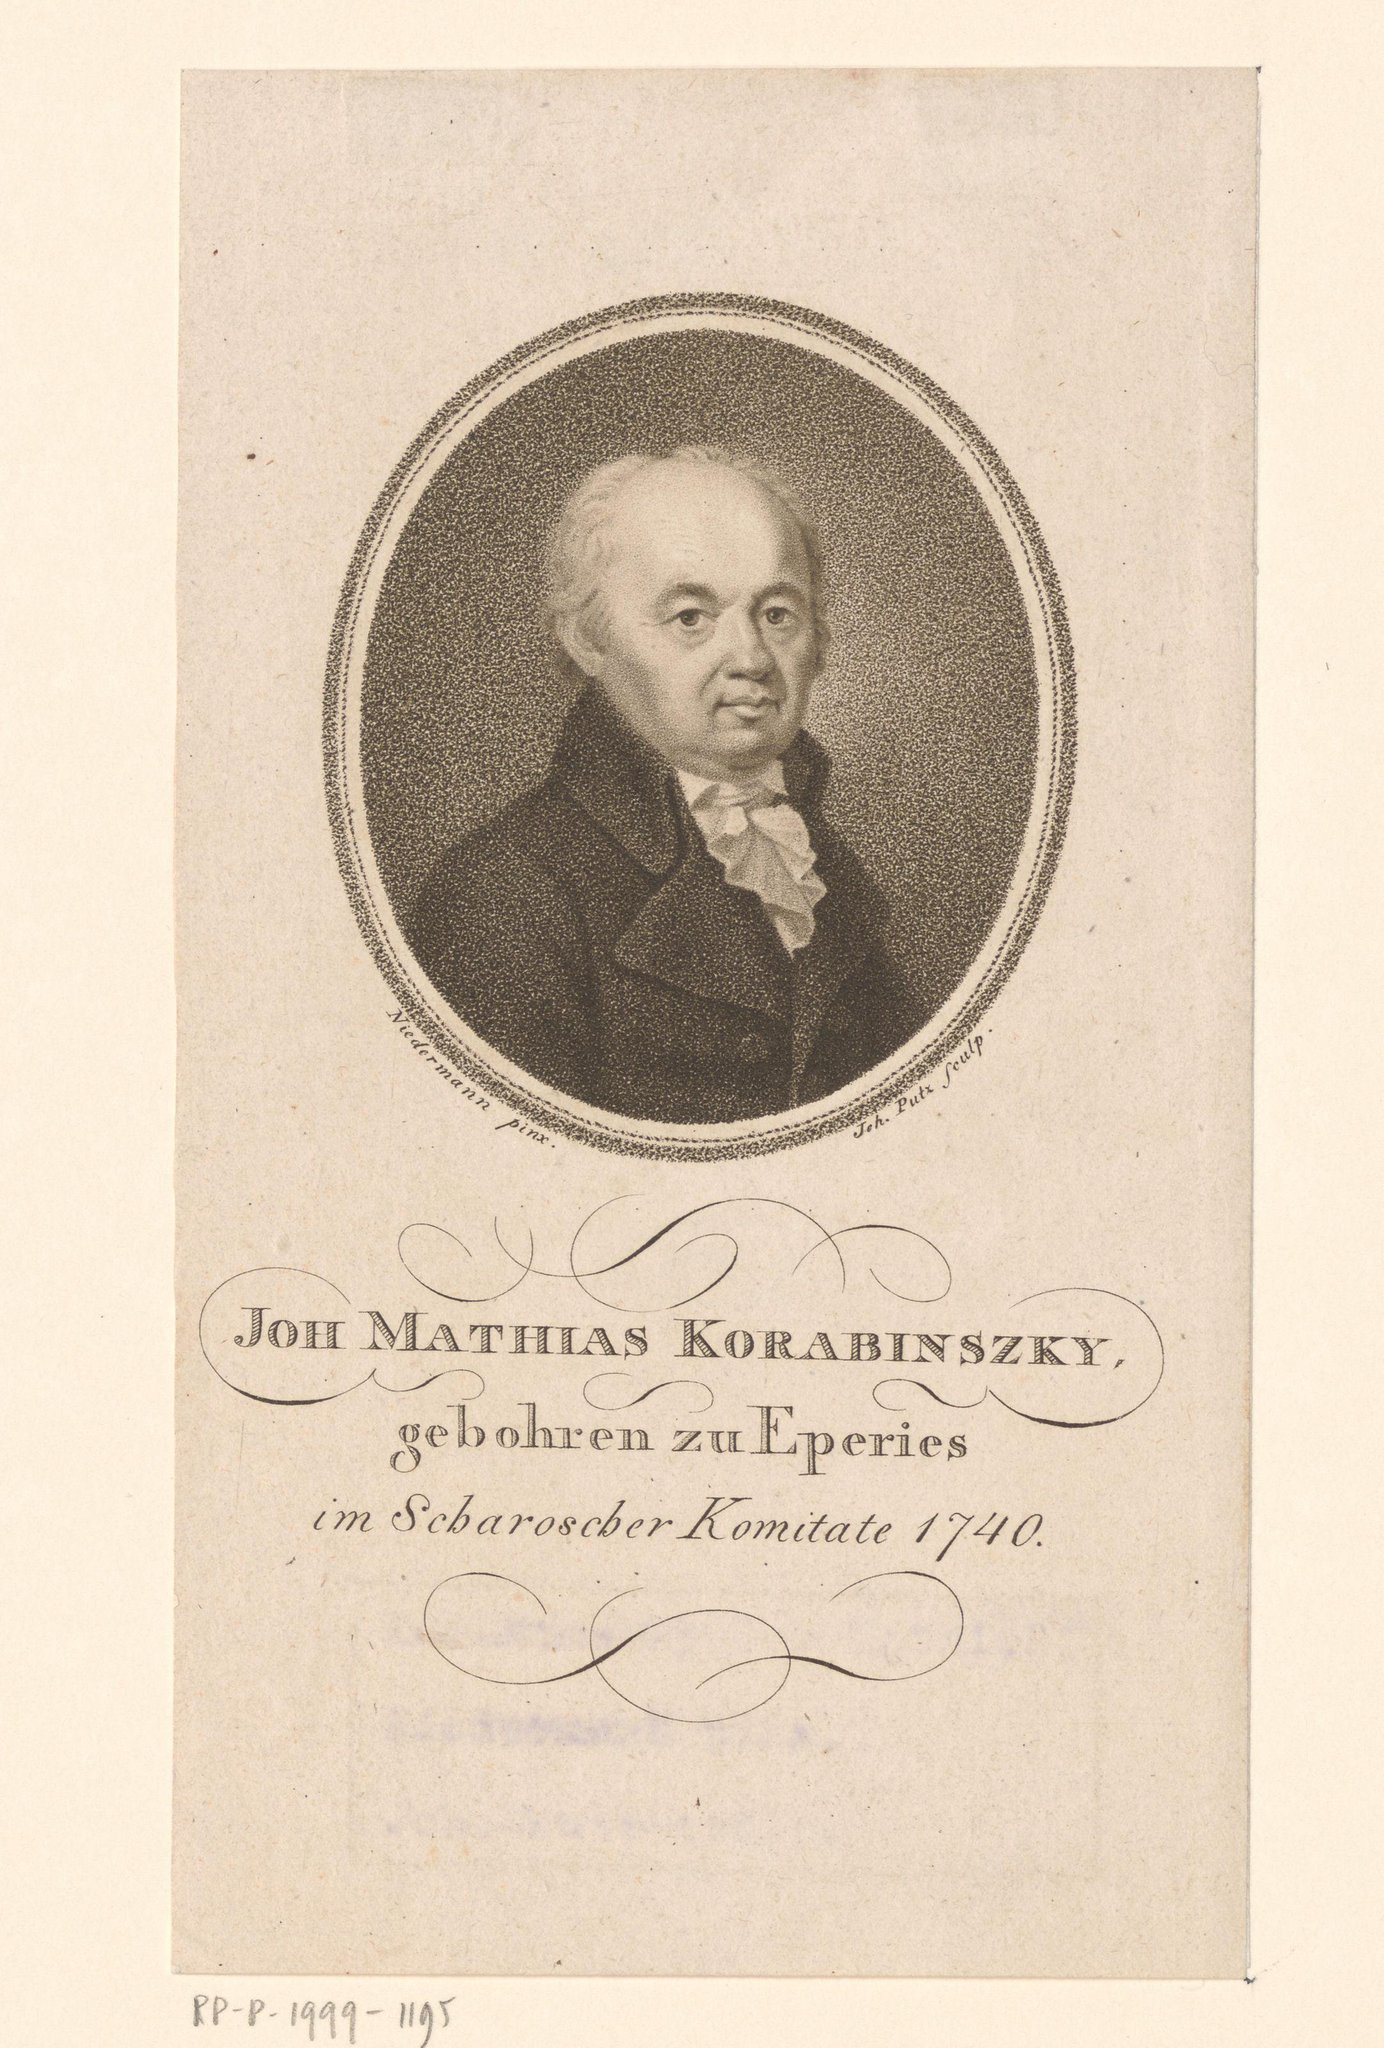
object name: print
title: Portret Johann Matthias Korabinszky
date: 1775-1849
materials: paper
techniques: engraving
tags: historical persons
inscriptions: : Lugt 2760, collector's mark: Lugt 2228